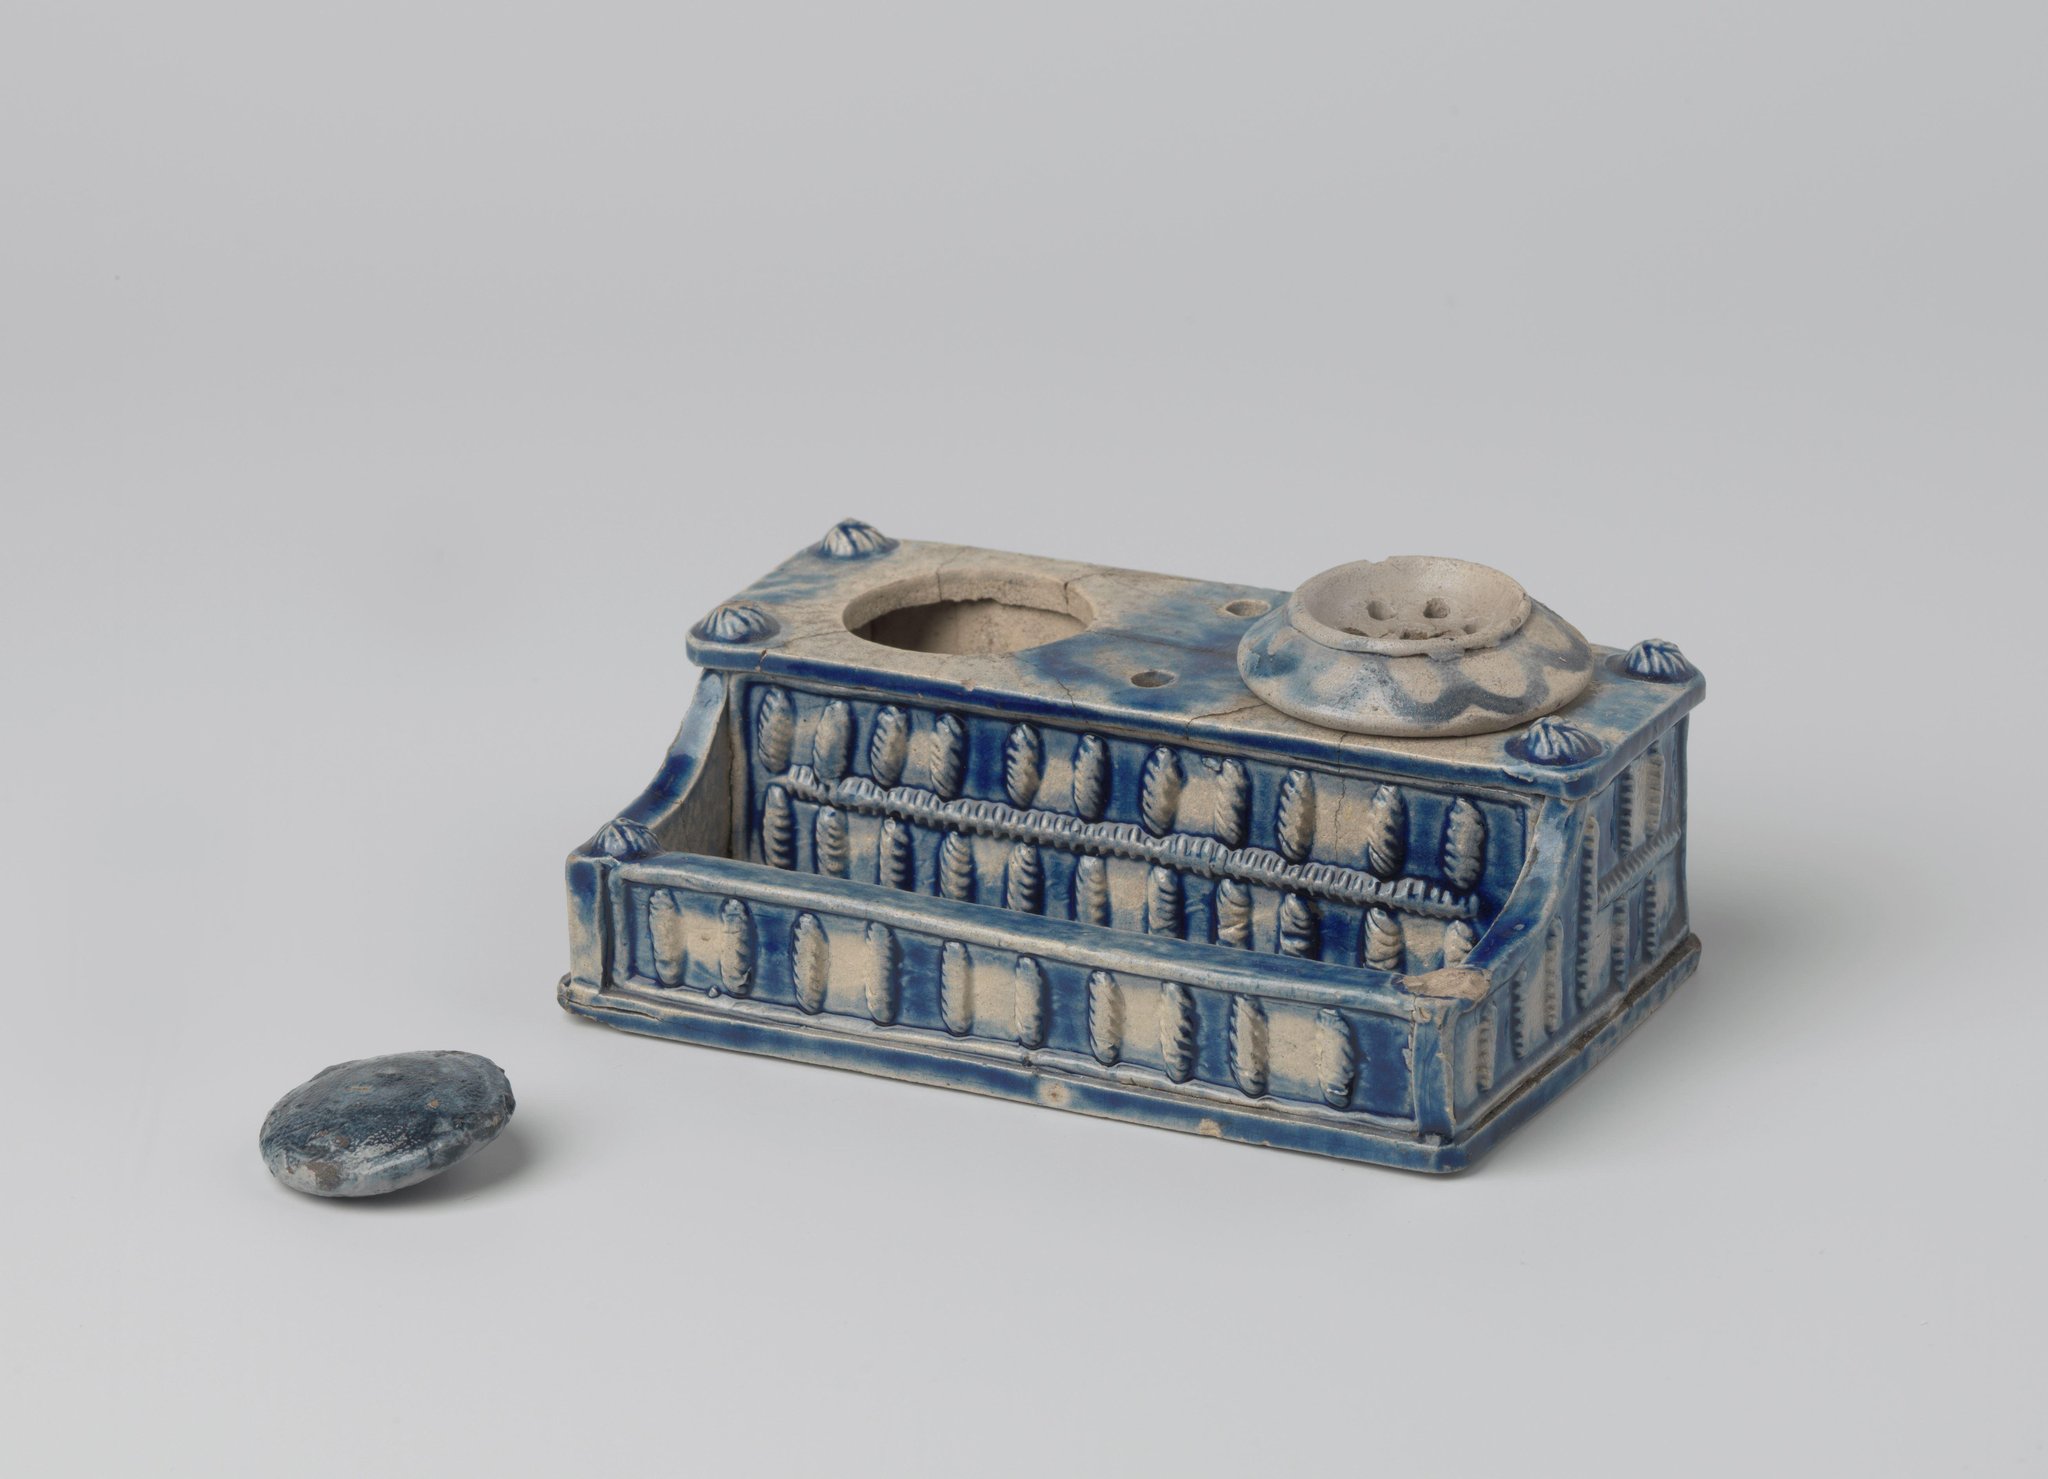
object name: inkstand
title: Ink stand with a relief decoration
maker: Anonymous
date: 1750-1799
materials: cobalt, glaze, stoneware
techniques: firing, forming, relief, vitrification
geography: westerwald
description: Inkstel van steengoed met een pennenbak en twee houders voor de inktpot en de zandstrooier. Gedeeltelijk bedekt met kobaltblauw. Het stel is versierd met een gedrukte en opgelegde reliëfdecoratie. Op elke hoek aan de bovenzijde een gemodelleerde 'klinknagel'. Westerwald.